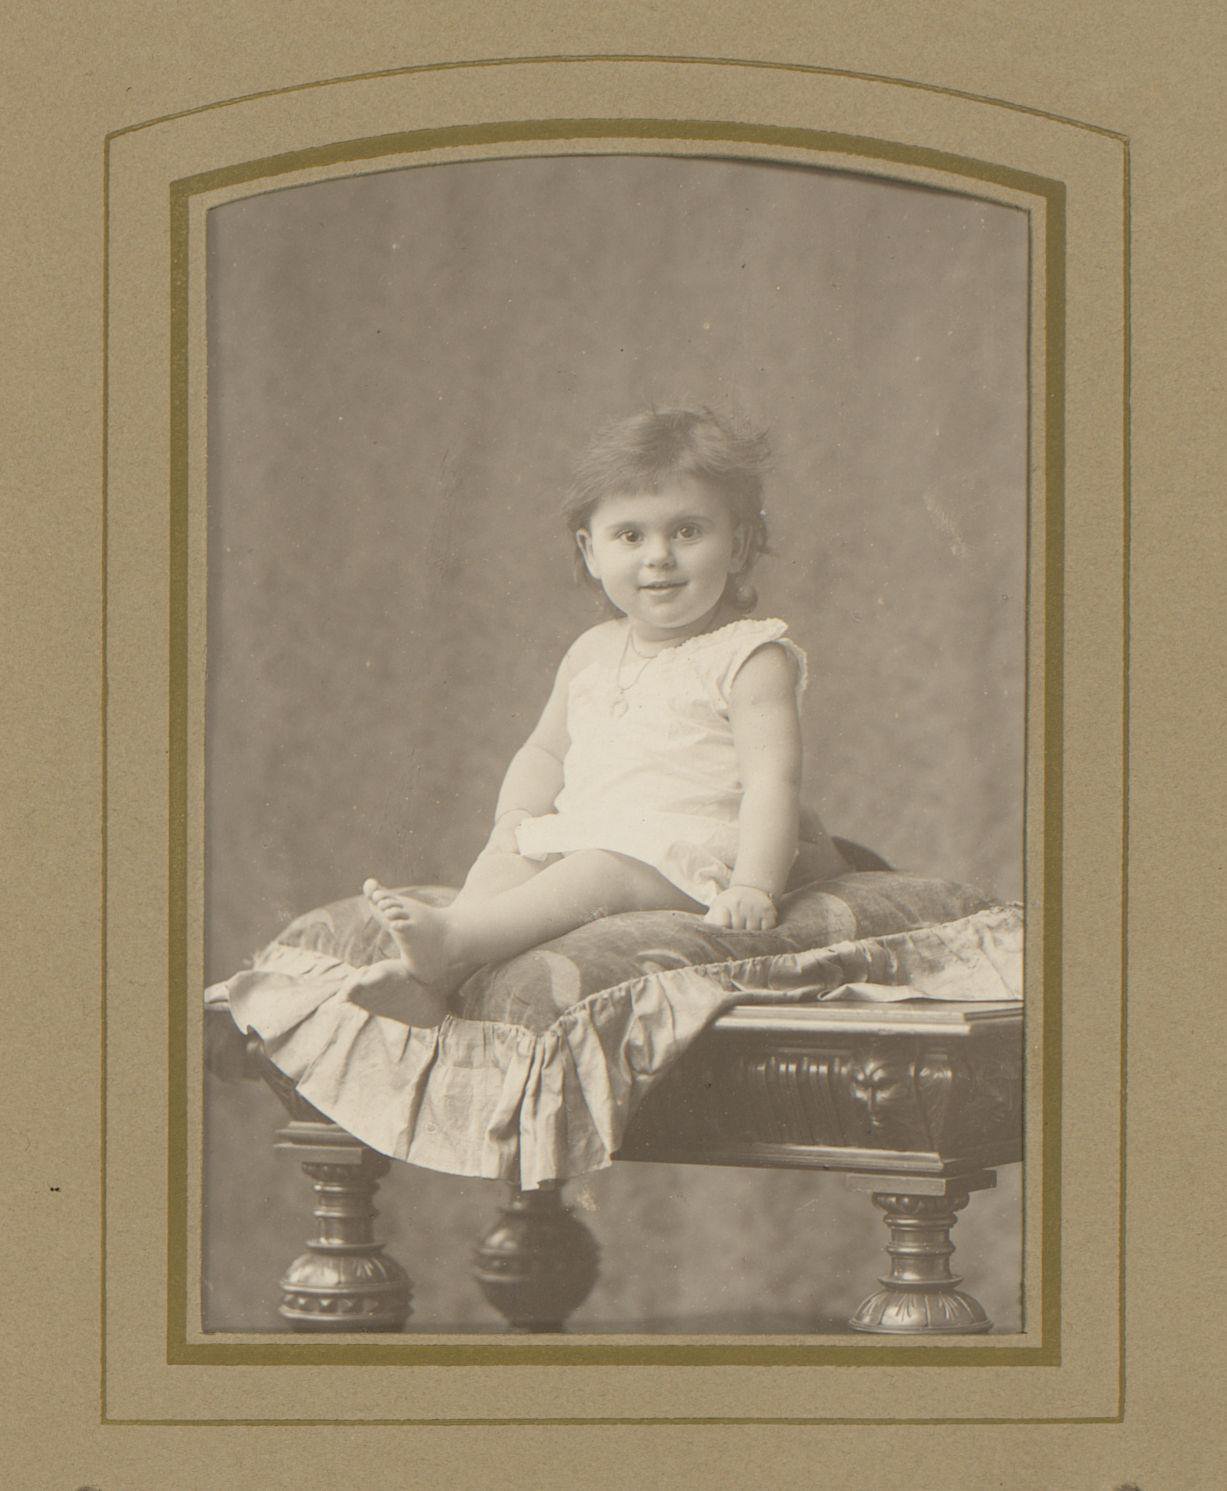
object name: cabinet photograph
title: Portret van een peuter op een kussen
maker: Anonymous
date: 1895-1920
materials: cardboard, photographic support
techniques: matte daylight collodion silver print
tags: historical persons, tot, toddler ~ the ages of man